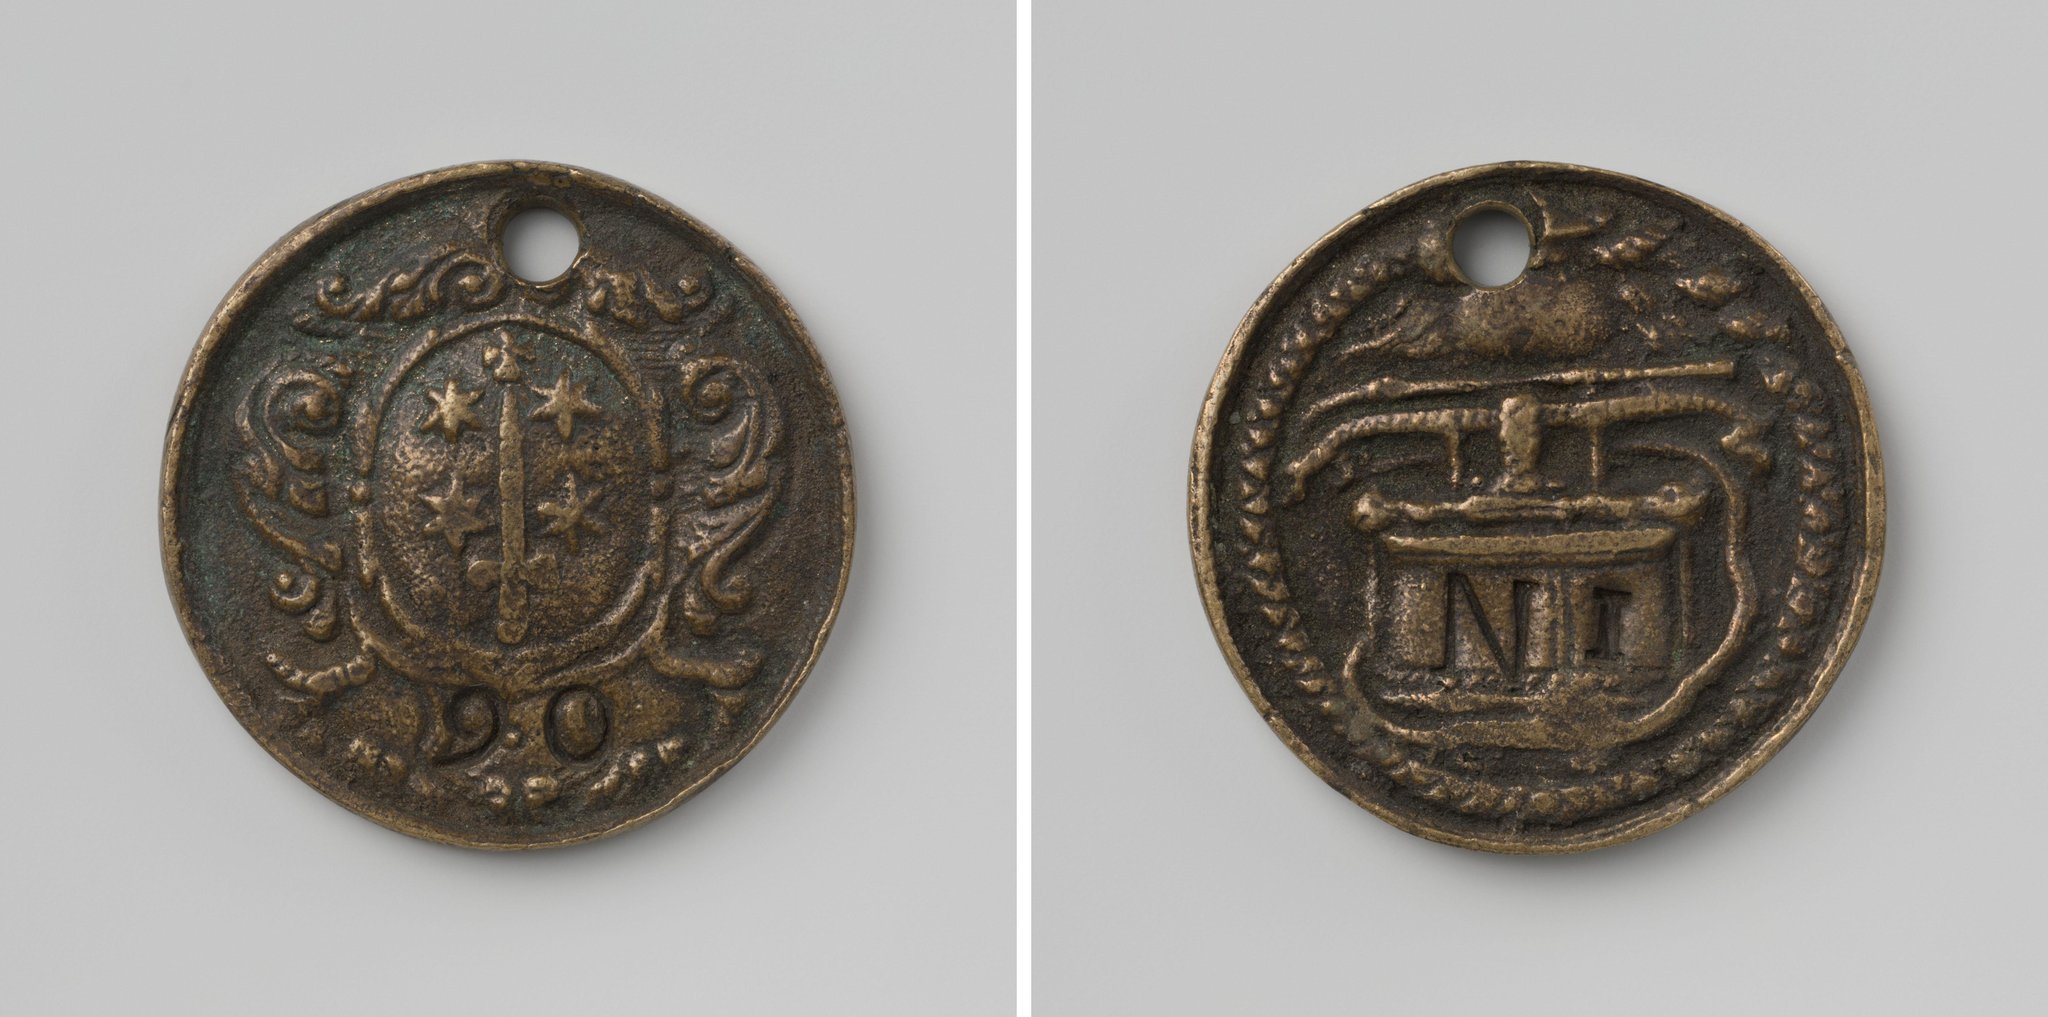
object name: fire engine medal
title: Haarlem, brandspuitpenning van spuit 1 met no. 90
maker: Anonymous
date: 1680-1800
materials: brass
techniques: casting, engraving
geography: haarlem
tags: haarlem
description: Messing penning met gat erin. Voorzijde: wapenschild in cartouche. Keerzijde: brandspuit onder leeg cartouche binnen slangerond; op zijde van brandspuit: cijfer N 1